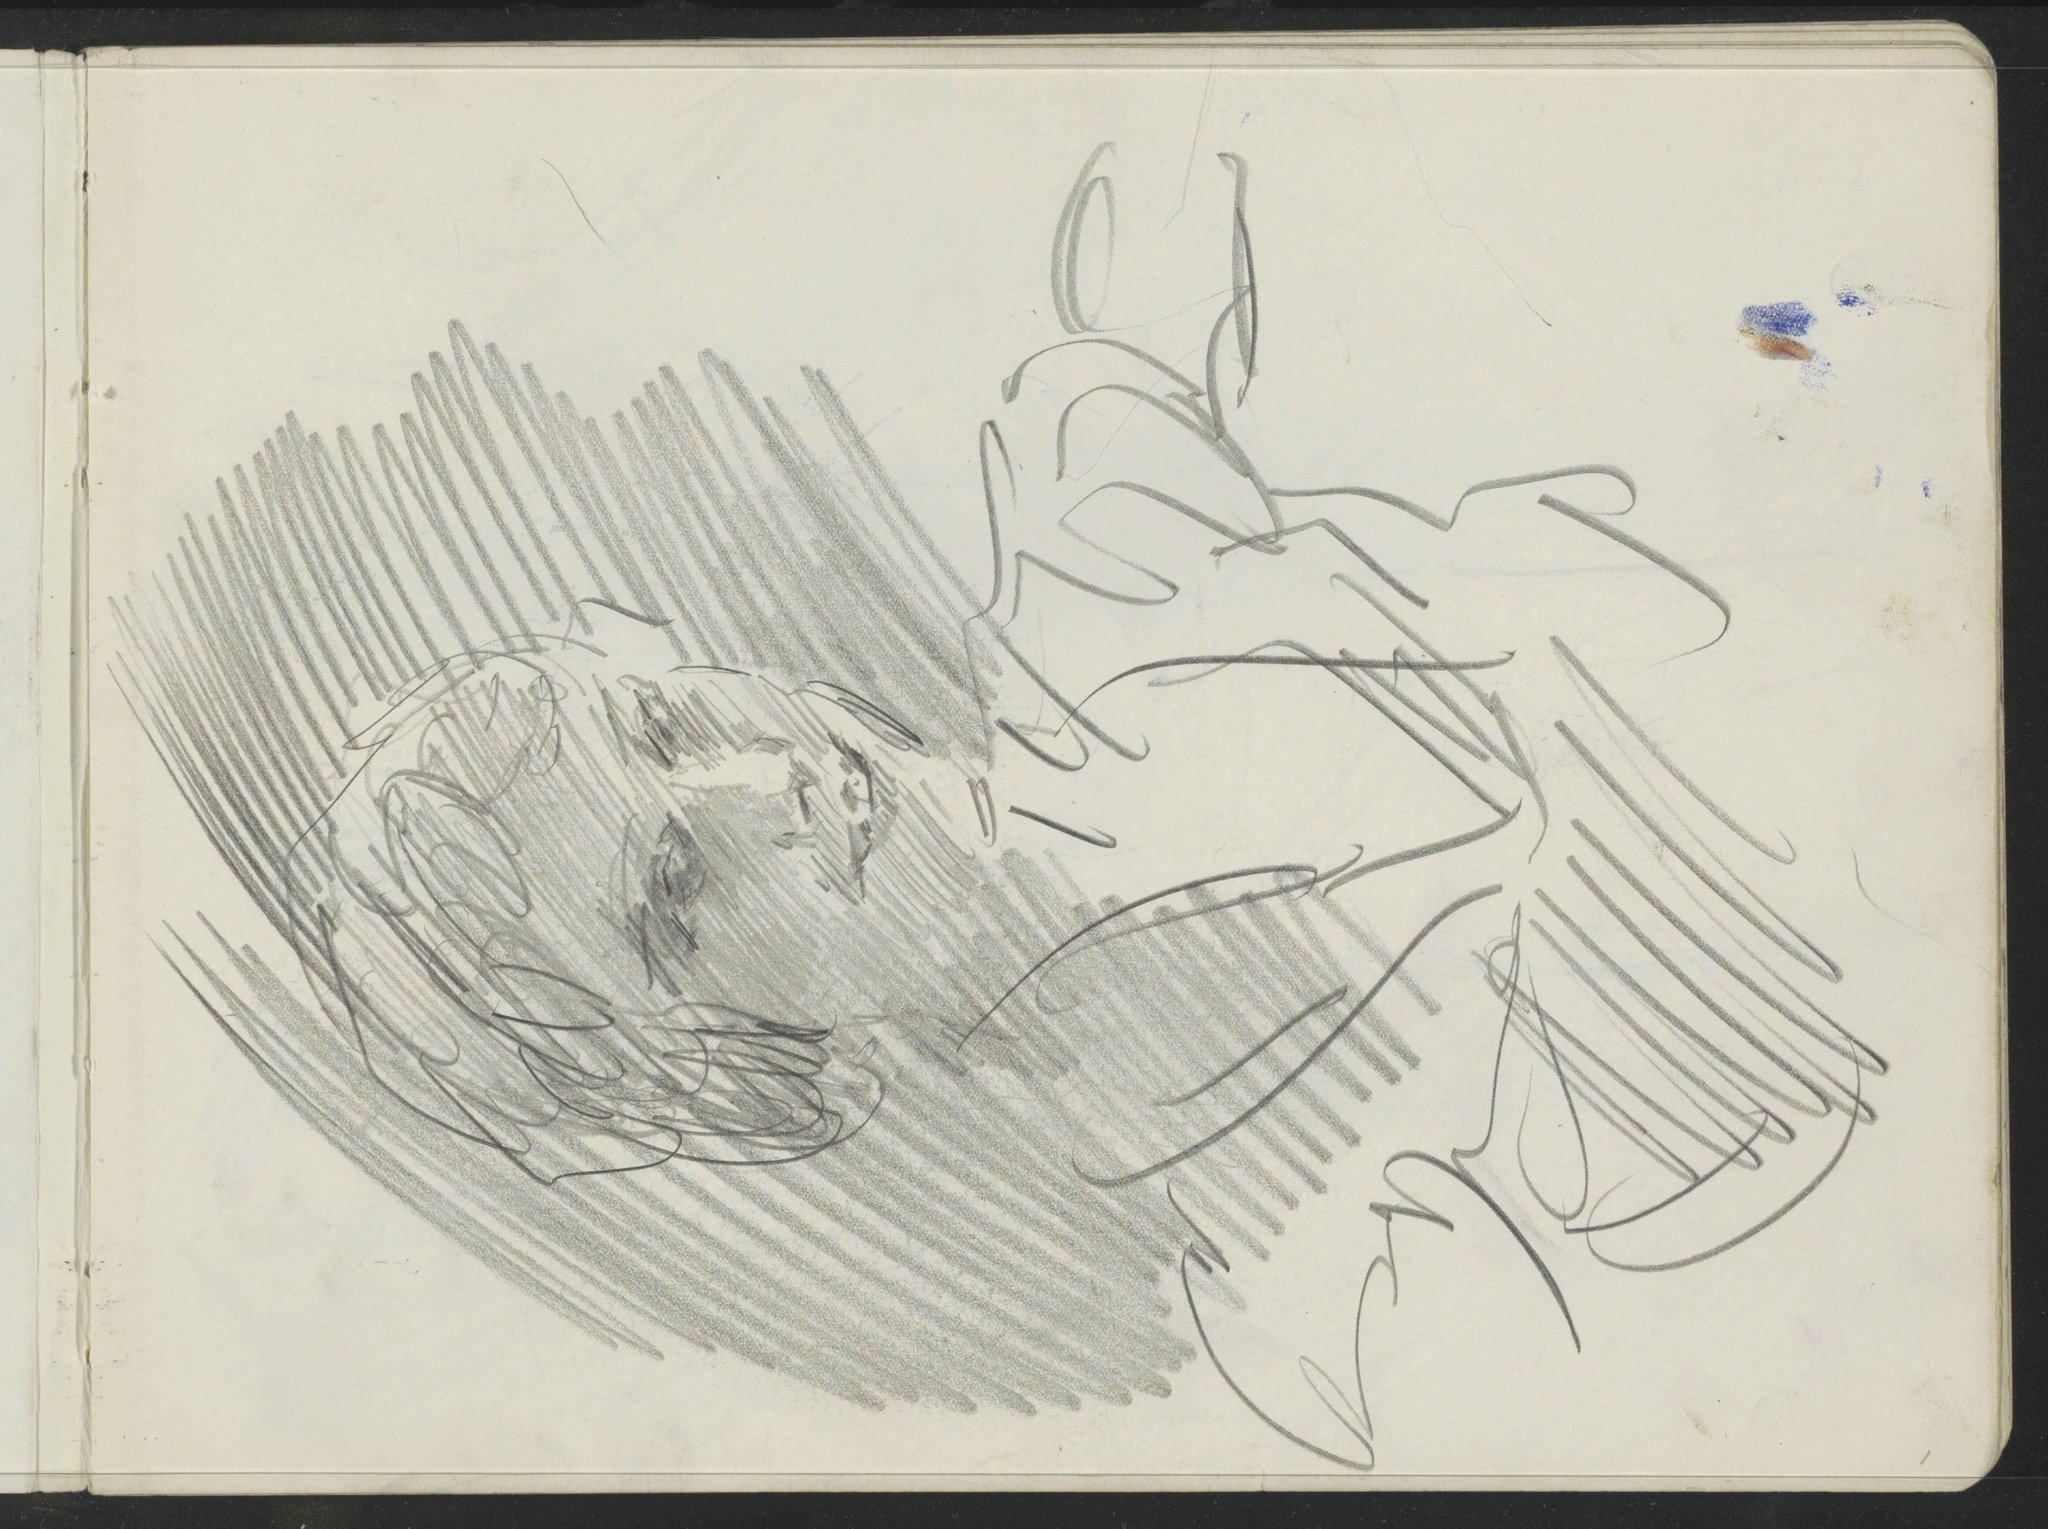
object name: sketchbook leaf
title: Vrouw, ten halven lijve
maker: isaac israels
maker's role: draughtsman, painter, print maker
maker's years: 1865-1934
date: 1915-1934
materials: paper, pencil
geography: the hague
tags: adult woman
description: Blad 1 recto uit schetsboek XVII met 31 bladen.